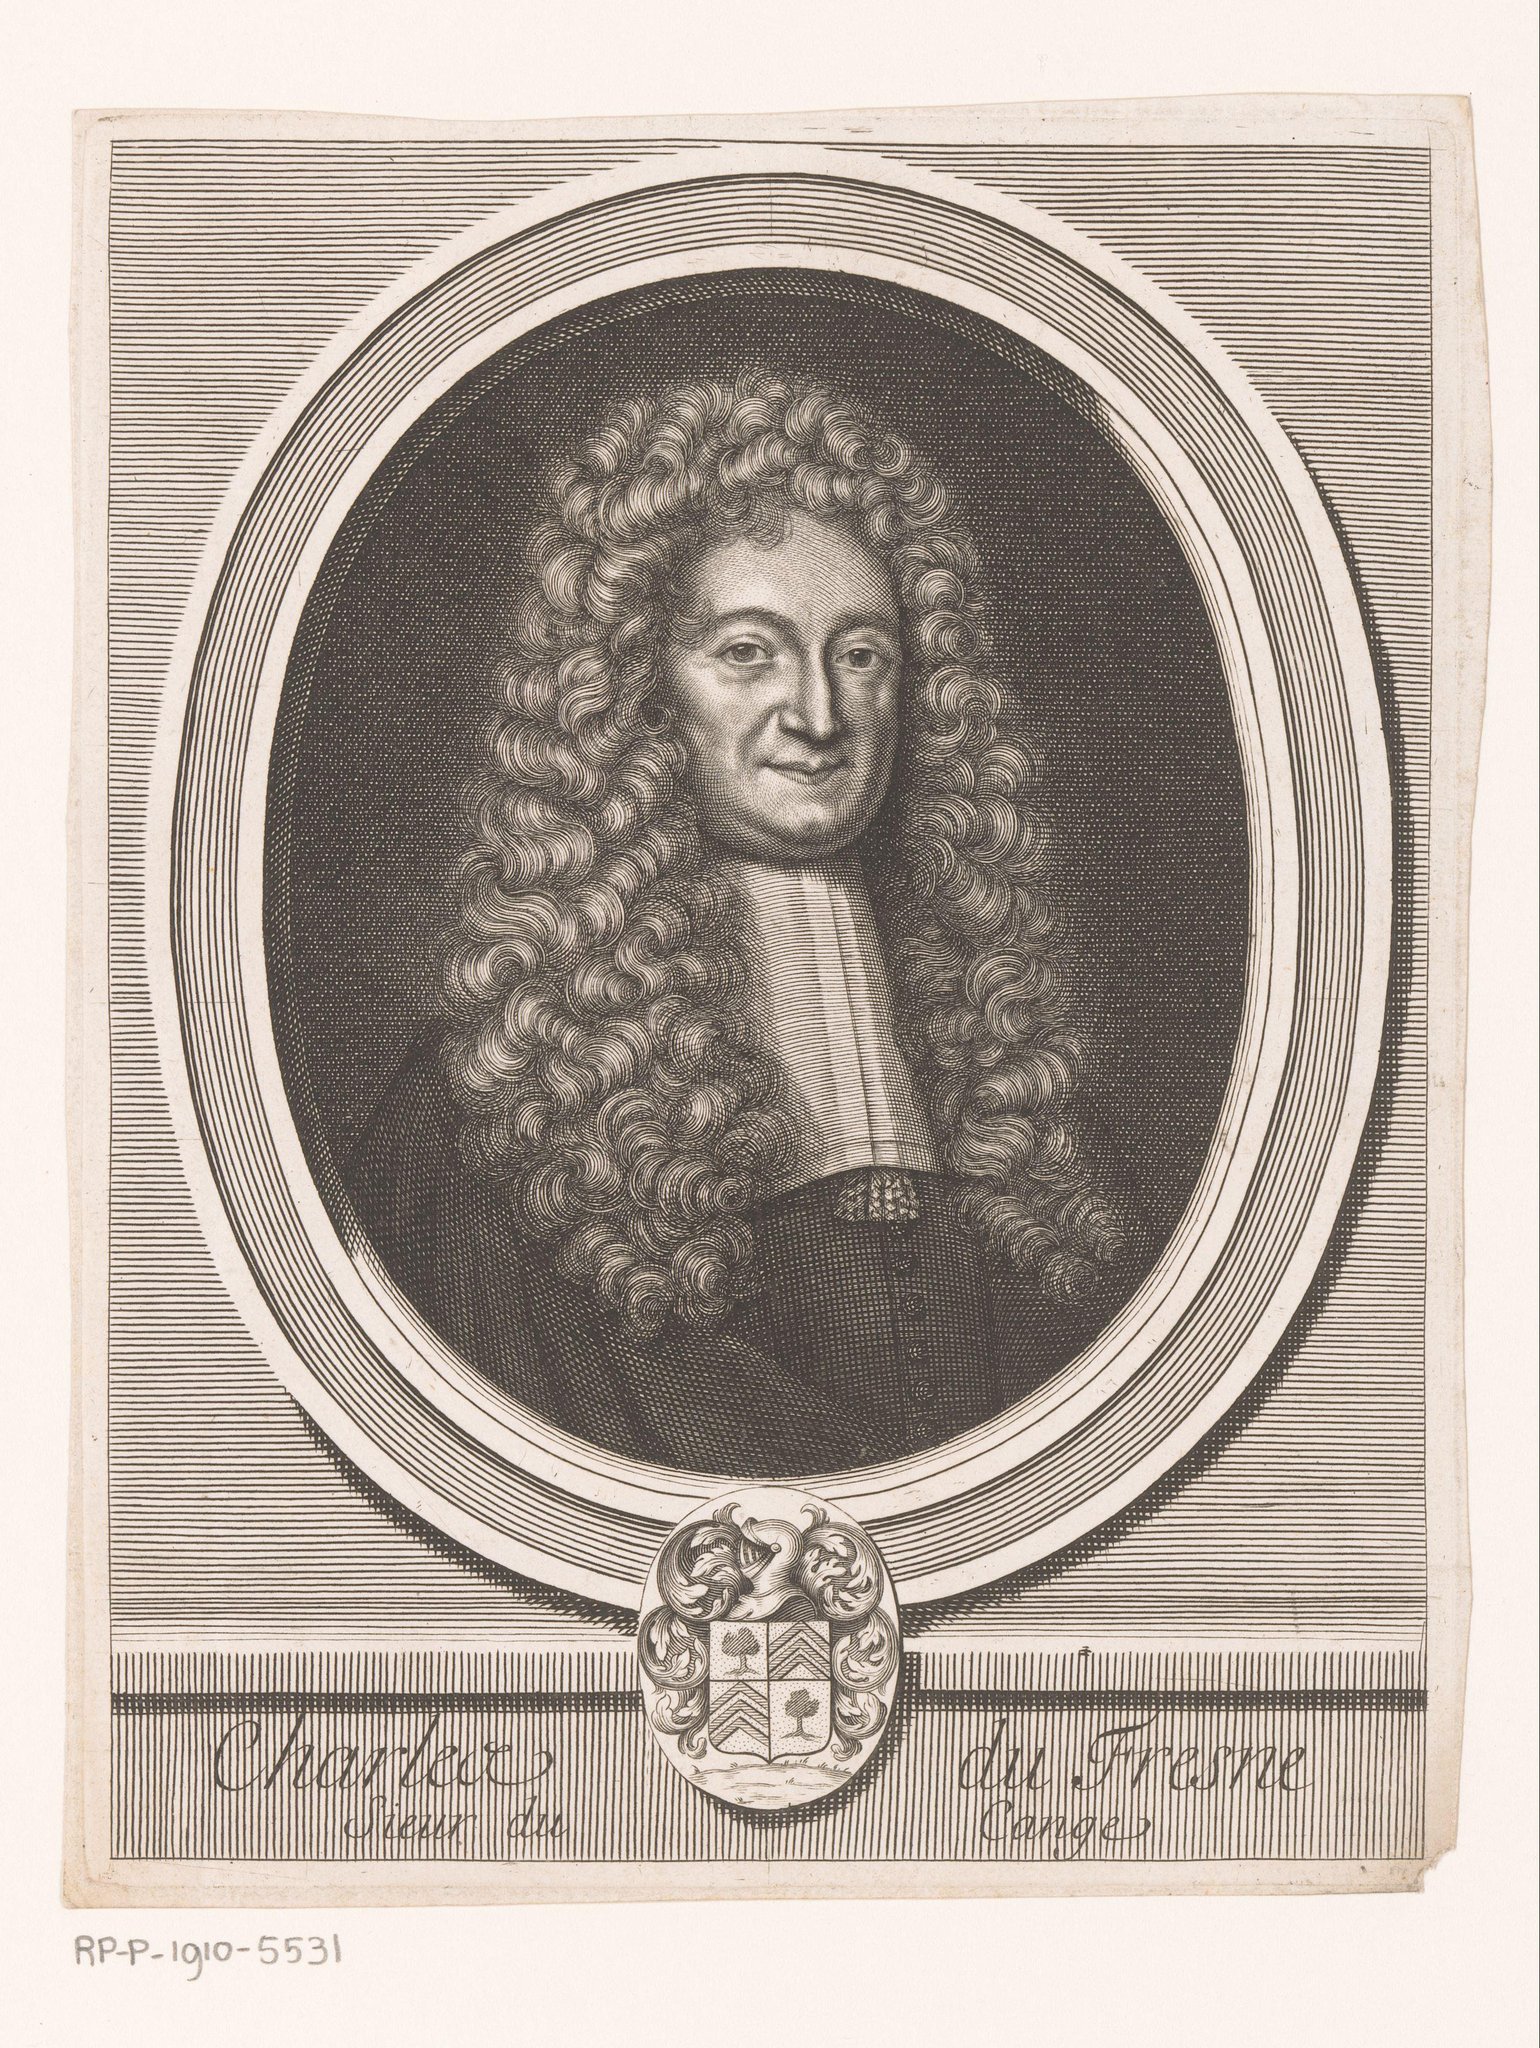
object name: book illustration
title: Portret van Charles du Fresne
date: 1696-1700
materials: paper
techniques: engraving, etching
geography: paris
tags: paris, historical persons, historical disciplines; philology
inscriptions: collector's mark: Lugt 2228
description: Prent uit: Perrault, Charles. Les hommes illustres qui ont paru en France pendant ce siècle. Parijs: Antoine Dezallier, 1696-1700.